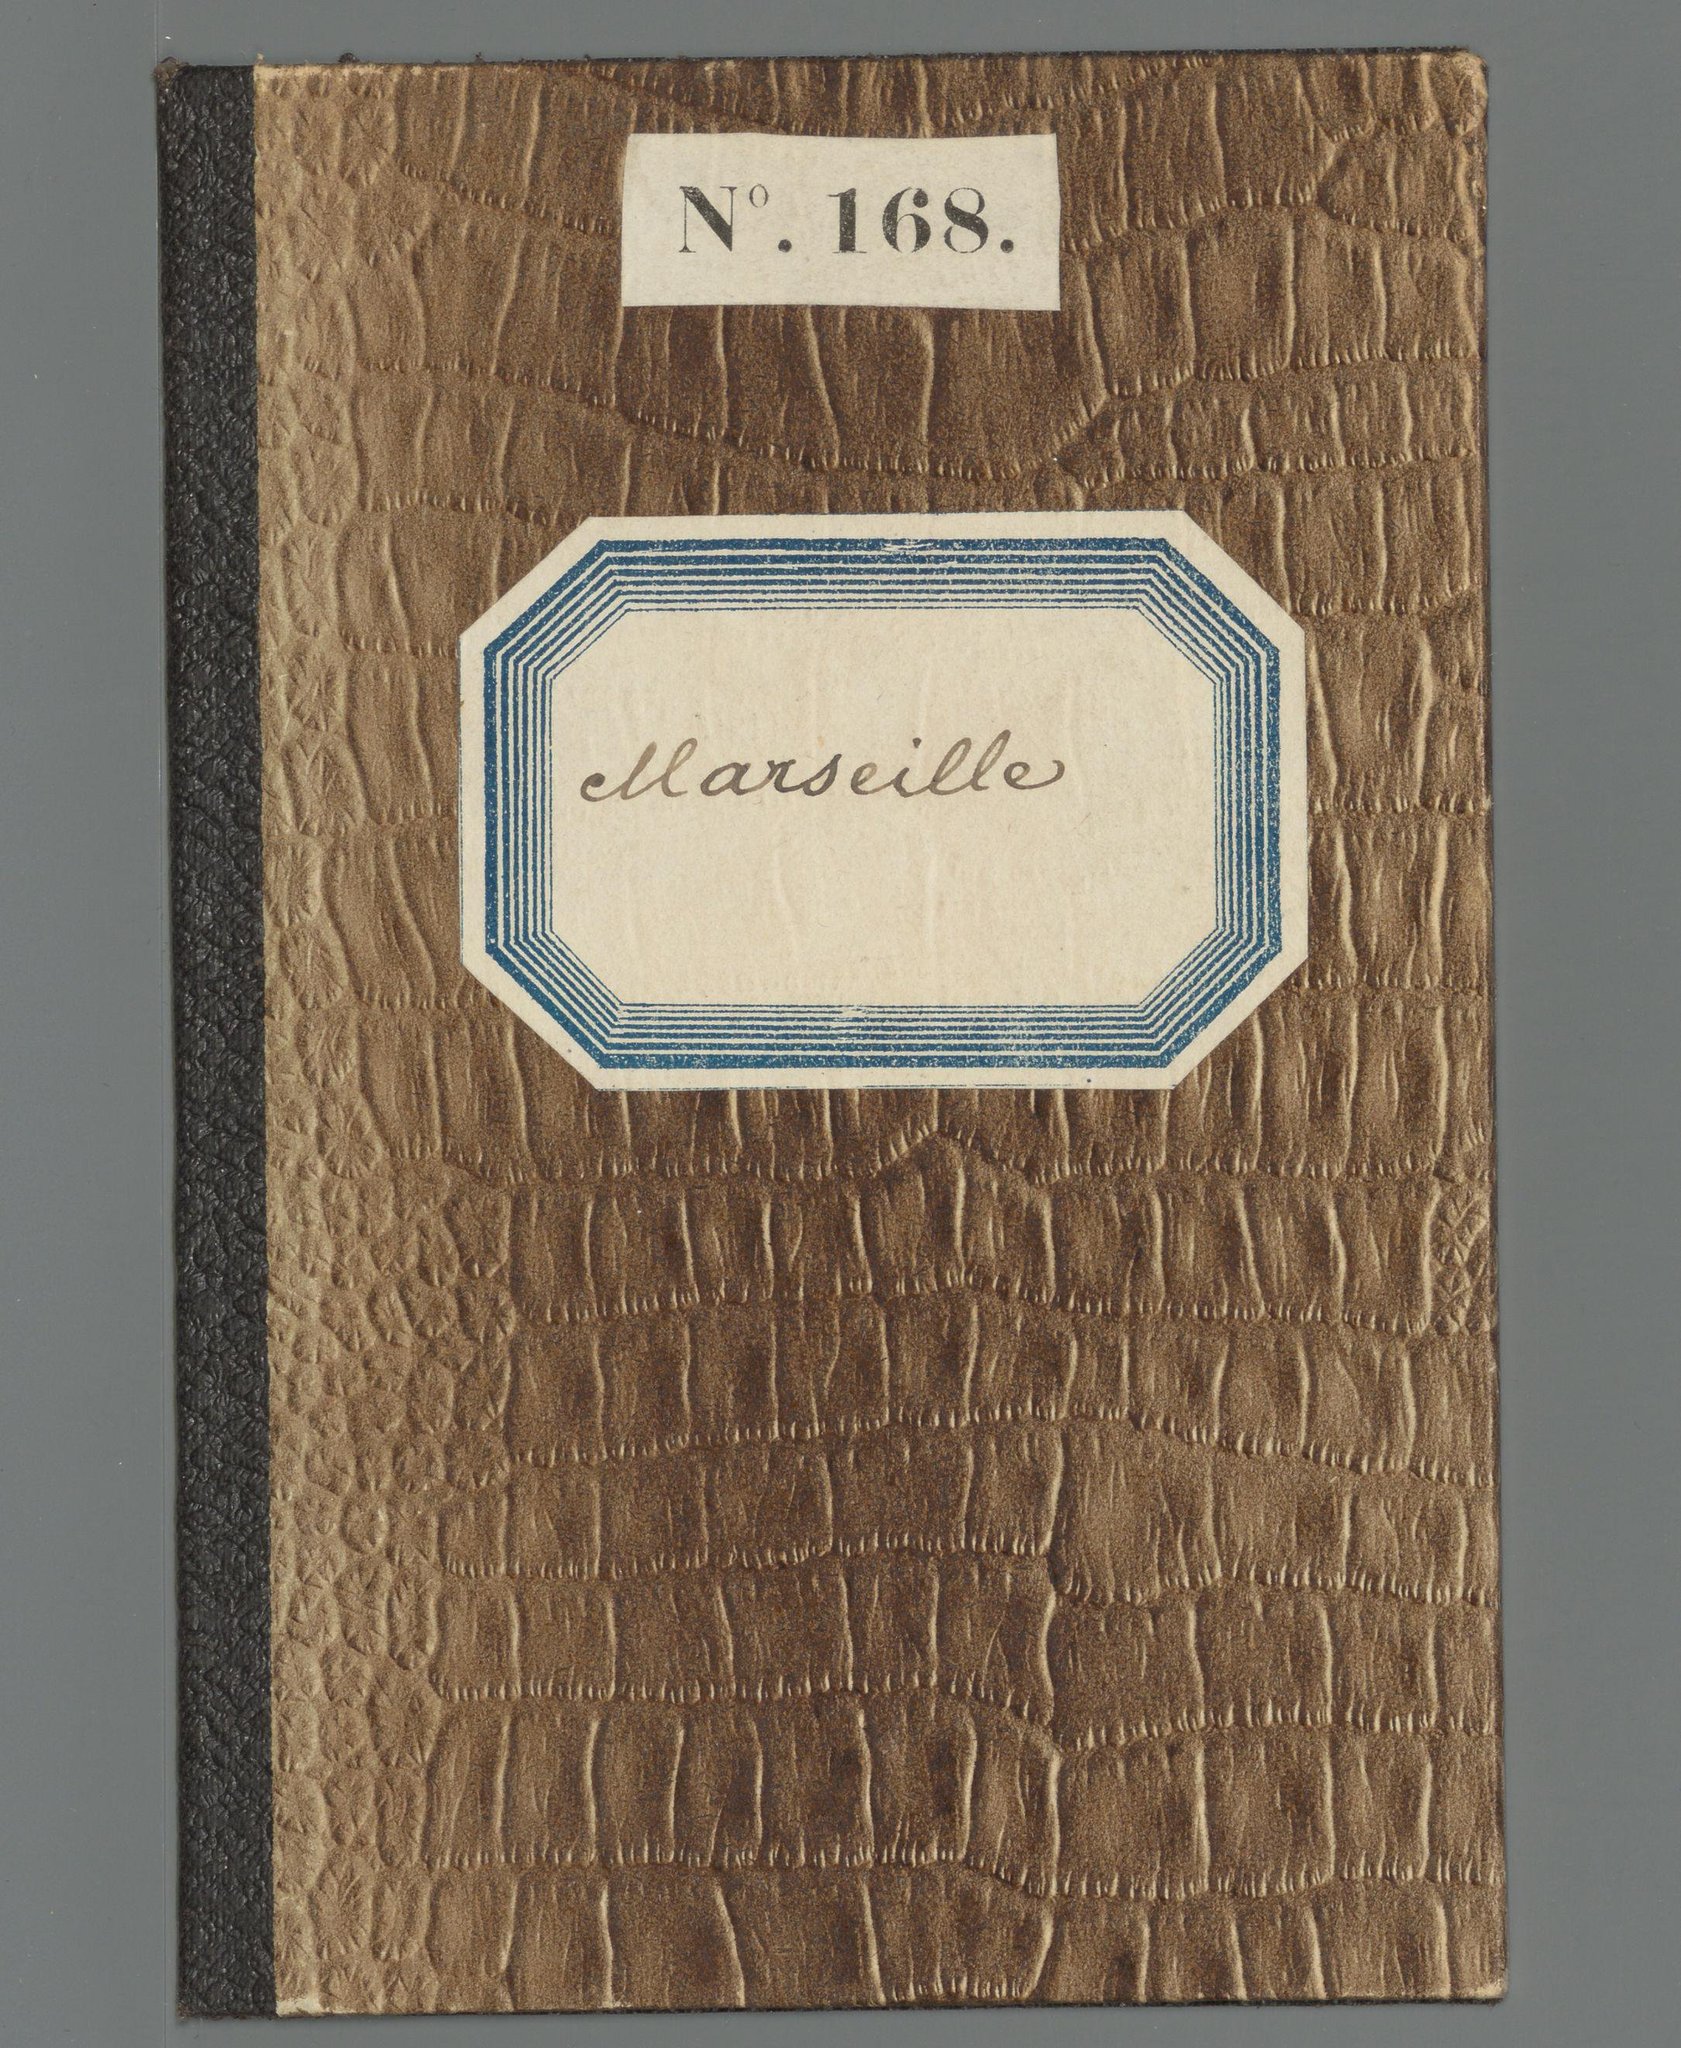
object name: wrapper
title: Marseille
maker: Anonymous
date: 1900-1950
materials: cardboard, ink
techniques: pen